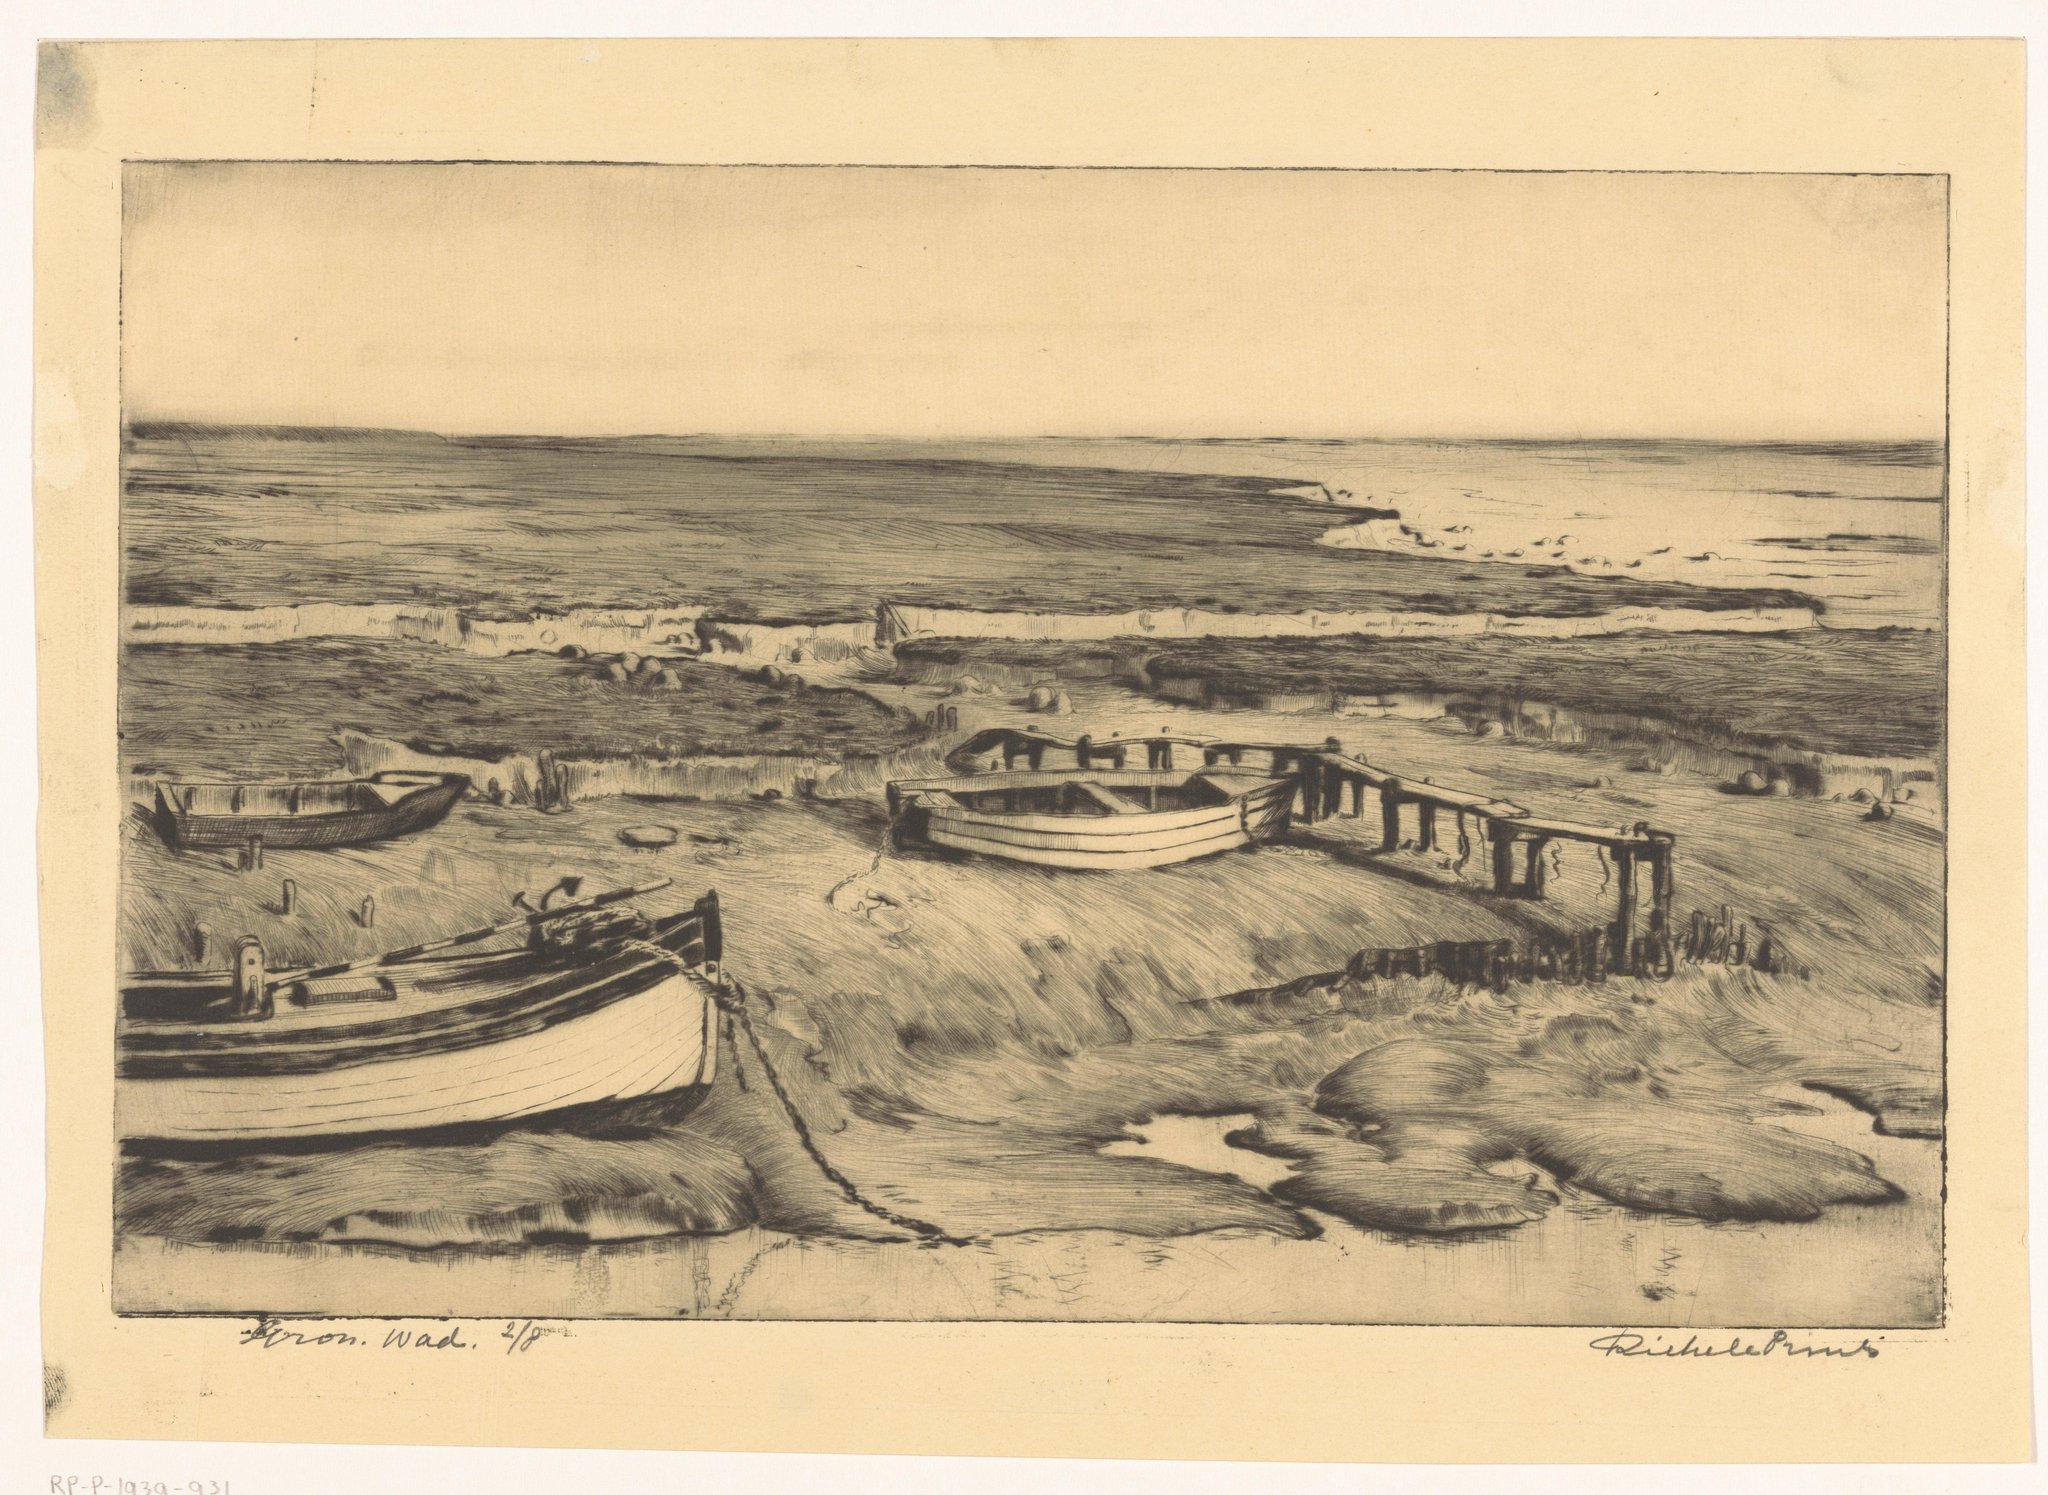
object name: print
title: Gezicht op het wad in Groningen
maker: riekele prins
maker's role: print maker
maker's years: 1905-1954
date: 1915-1939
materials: paper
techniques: drypoint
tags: mud flat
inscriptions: collector's mark: Lugt 2760, collector's mark: Lugt 2228